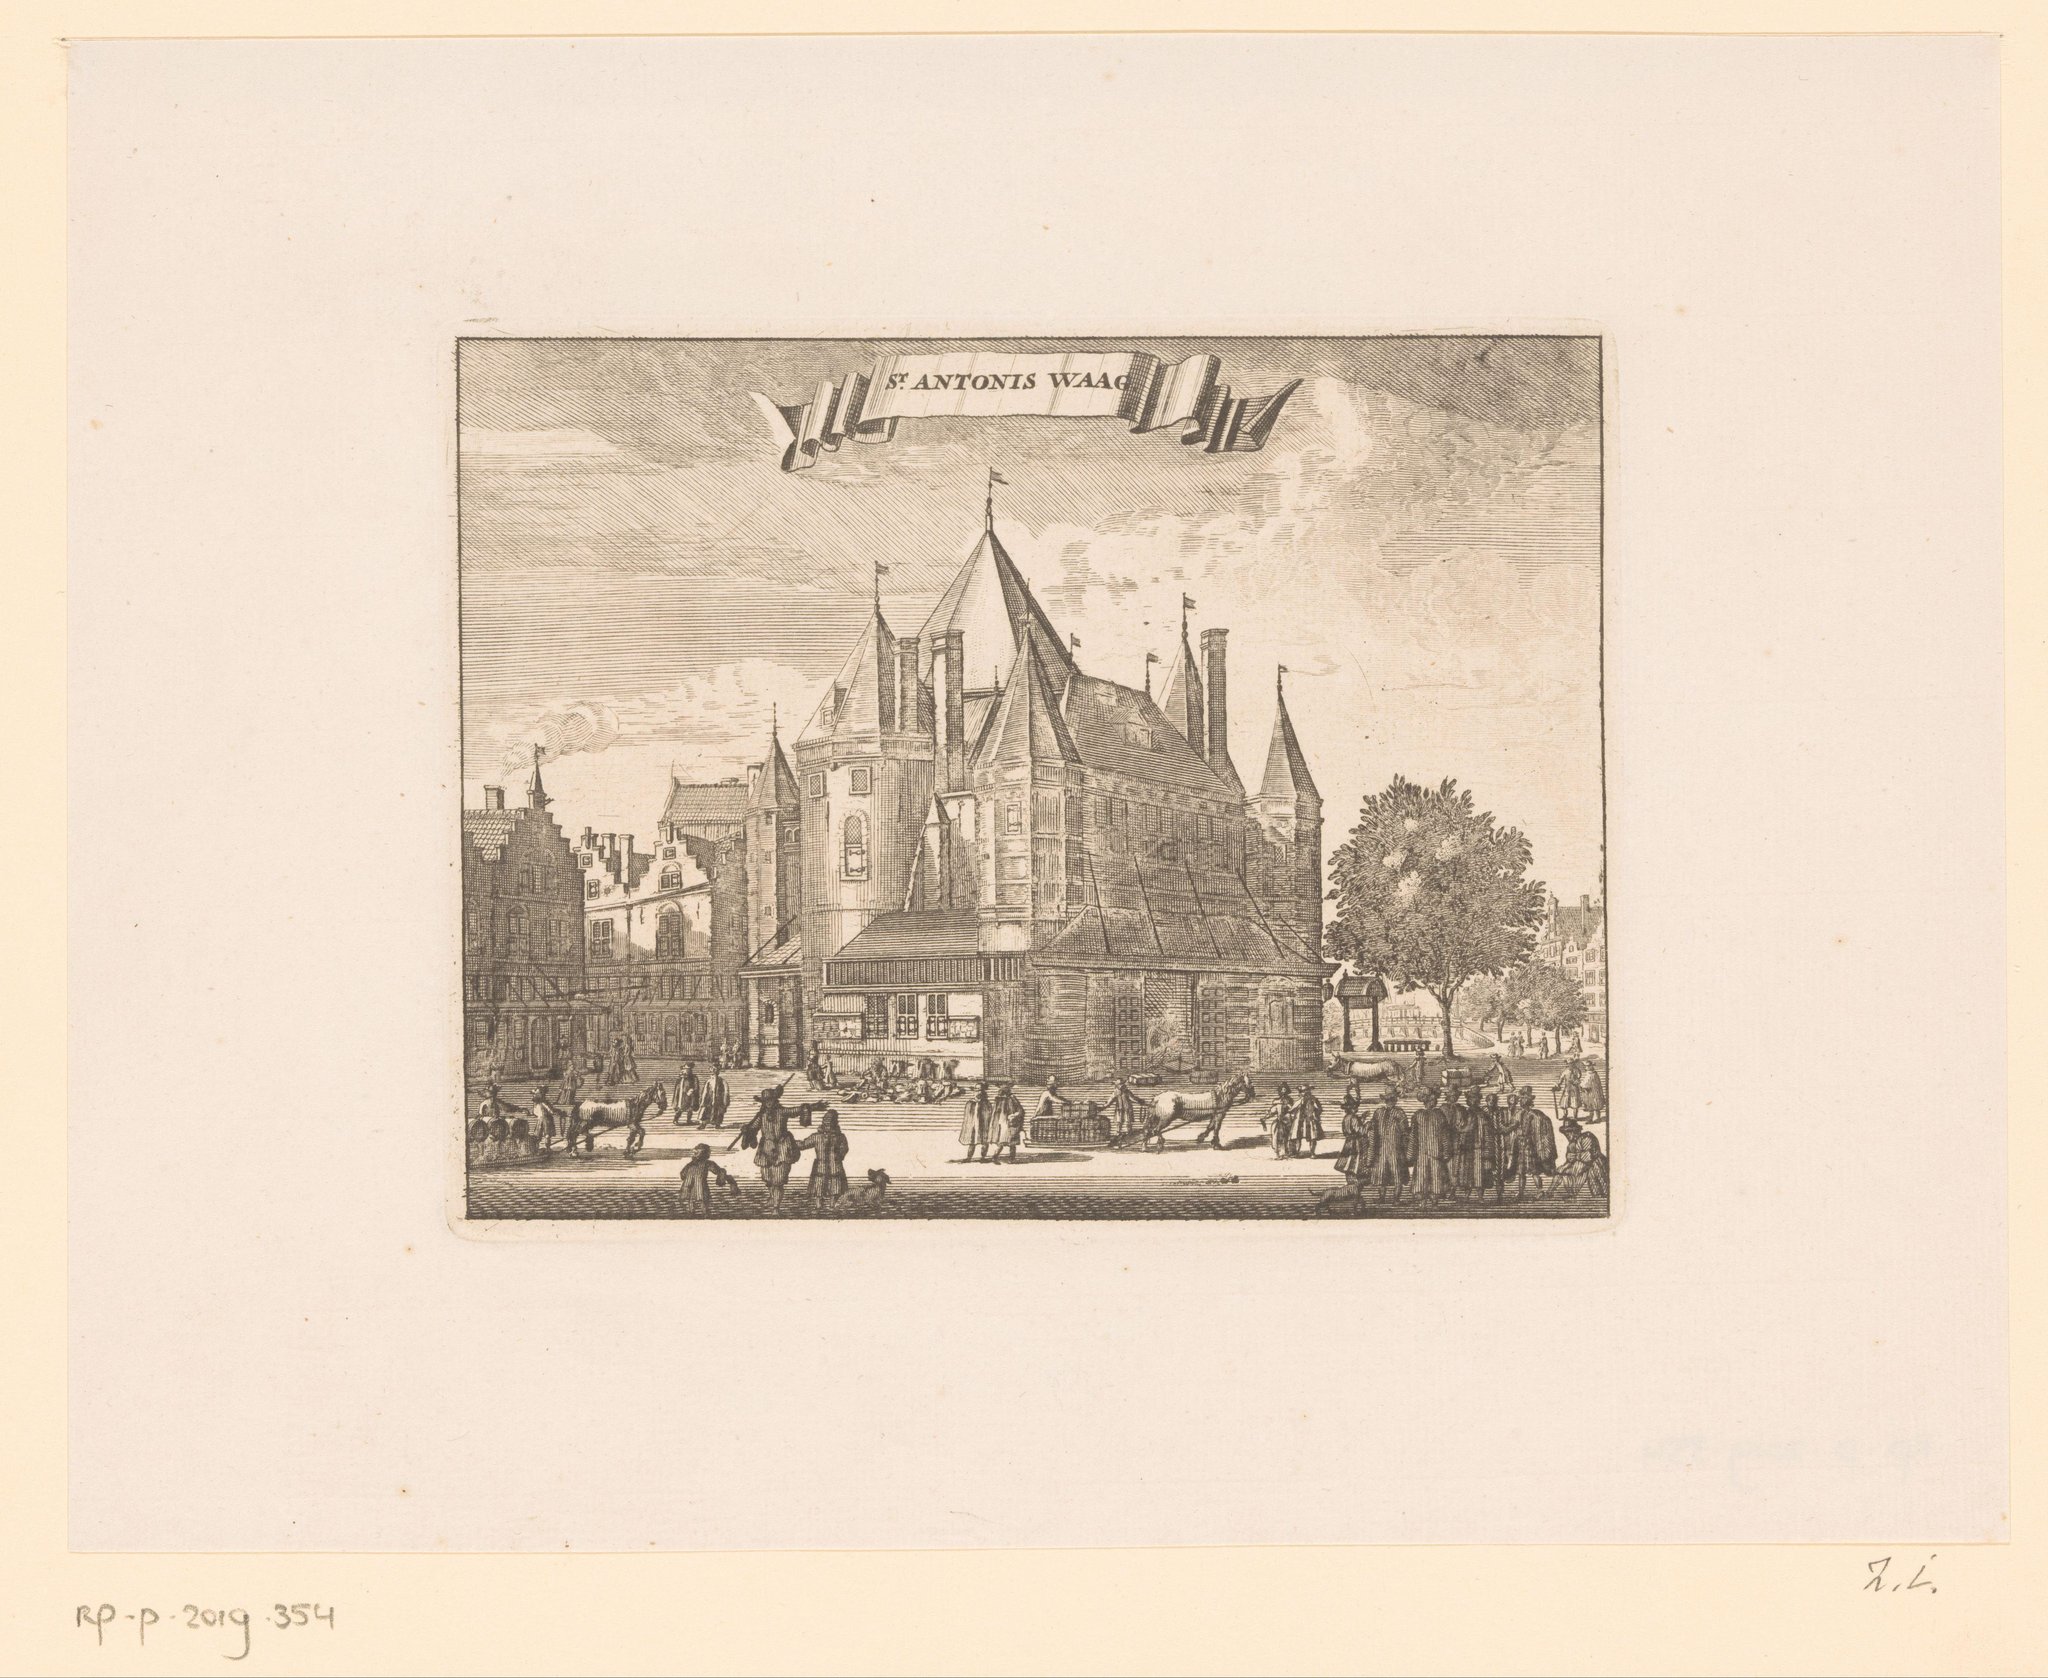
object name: print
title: St. Antonis Waag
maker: Anonymous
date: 1726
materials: paper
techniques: engraving, etching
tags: weigh-house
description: Deze prent ook gebruikt in: Commelin, Caspar. Beschryvinge van Amsterdam (...). Amsterdam: Andries van Damme et al., 1726, dl. 2, p. 630. In het boek heeft de prent echter tekst op het verso, wat bij dit exemplaar niet het geval is. Mogelijk een latere, losse uitgave van de prent.